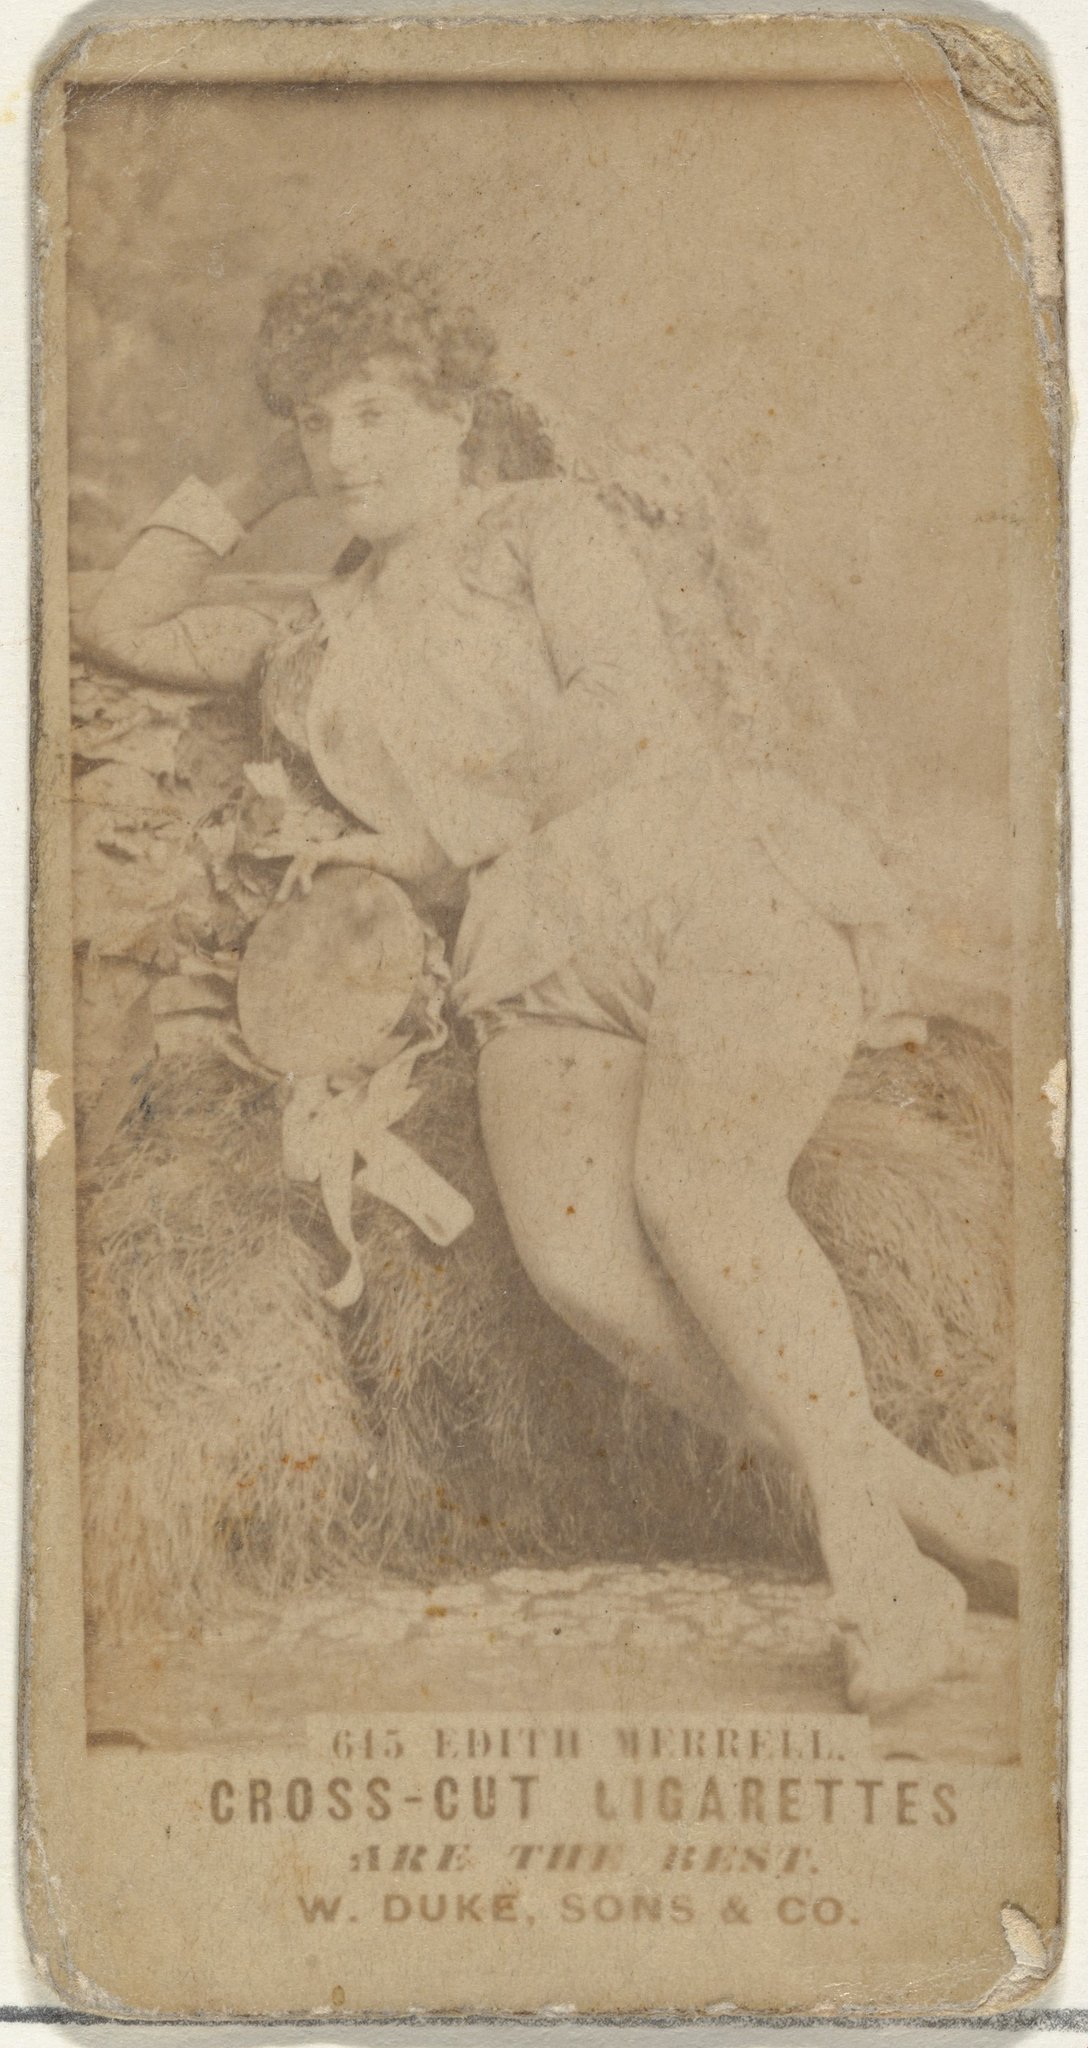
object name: photograph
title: Card Number 615, Edith Merrell, from the Actors and Actresses series (N145-3) issued by Duke Sons & Co. to promote Cross Cut Cigarettes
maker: w. duke, sons & co.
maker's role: publisher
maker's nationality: american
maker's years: 1870-1920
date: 1880-1889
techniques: albumen silver print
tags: portraits,women,actresses